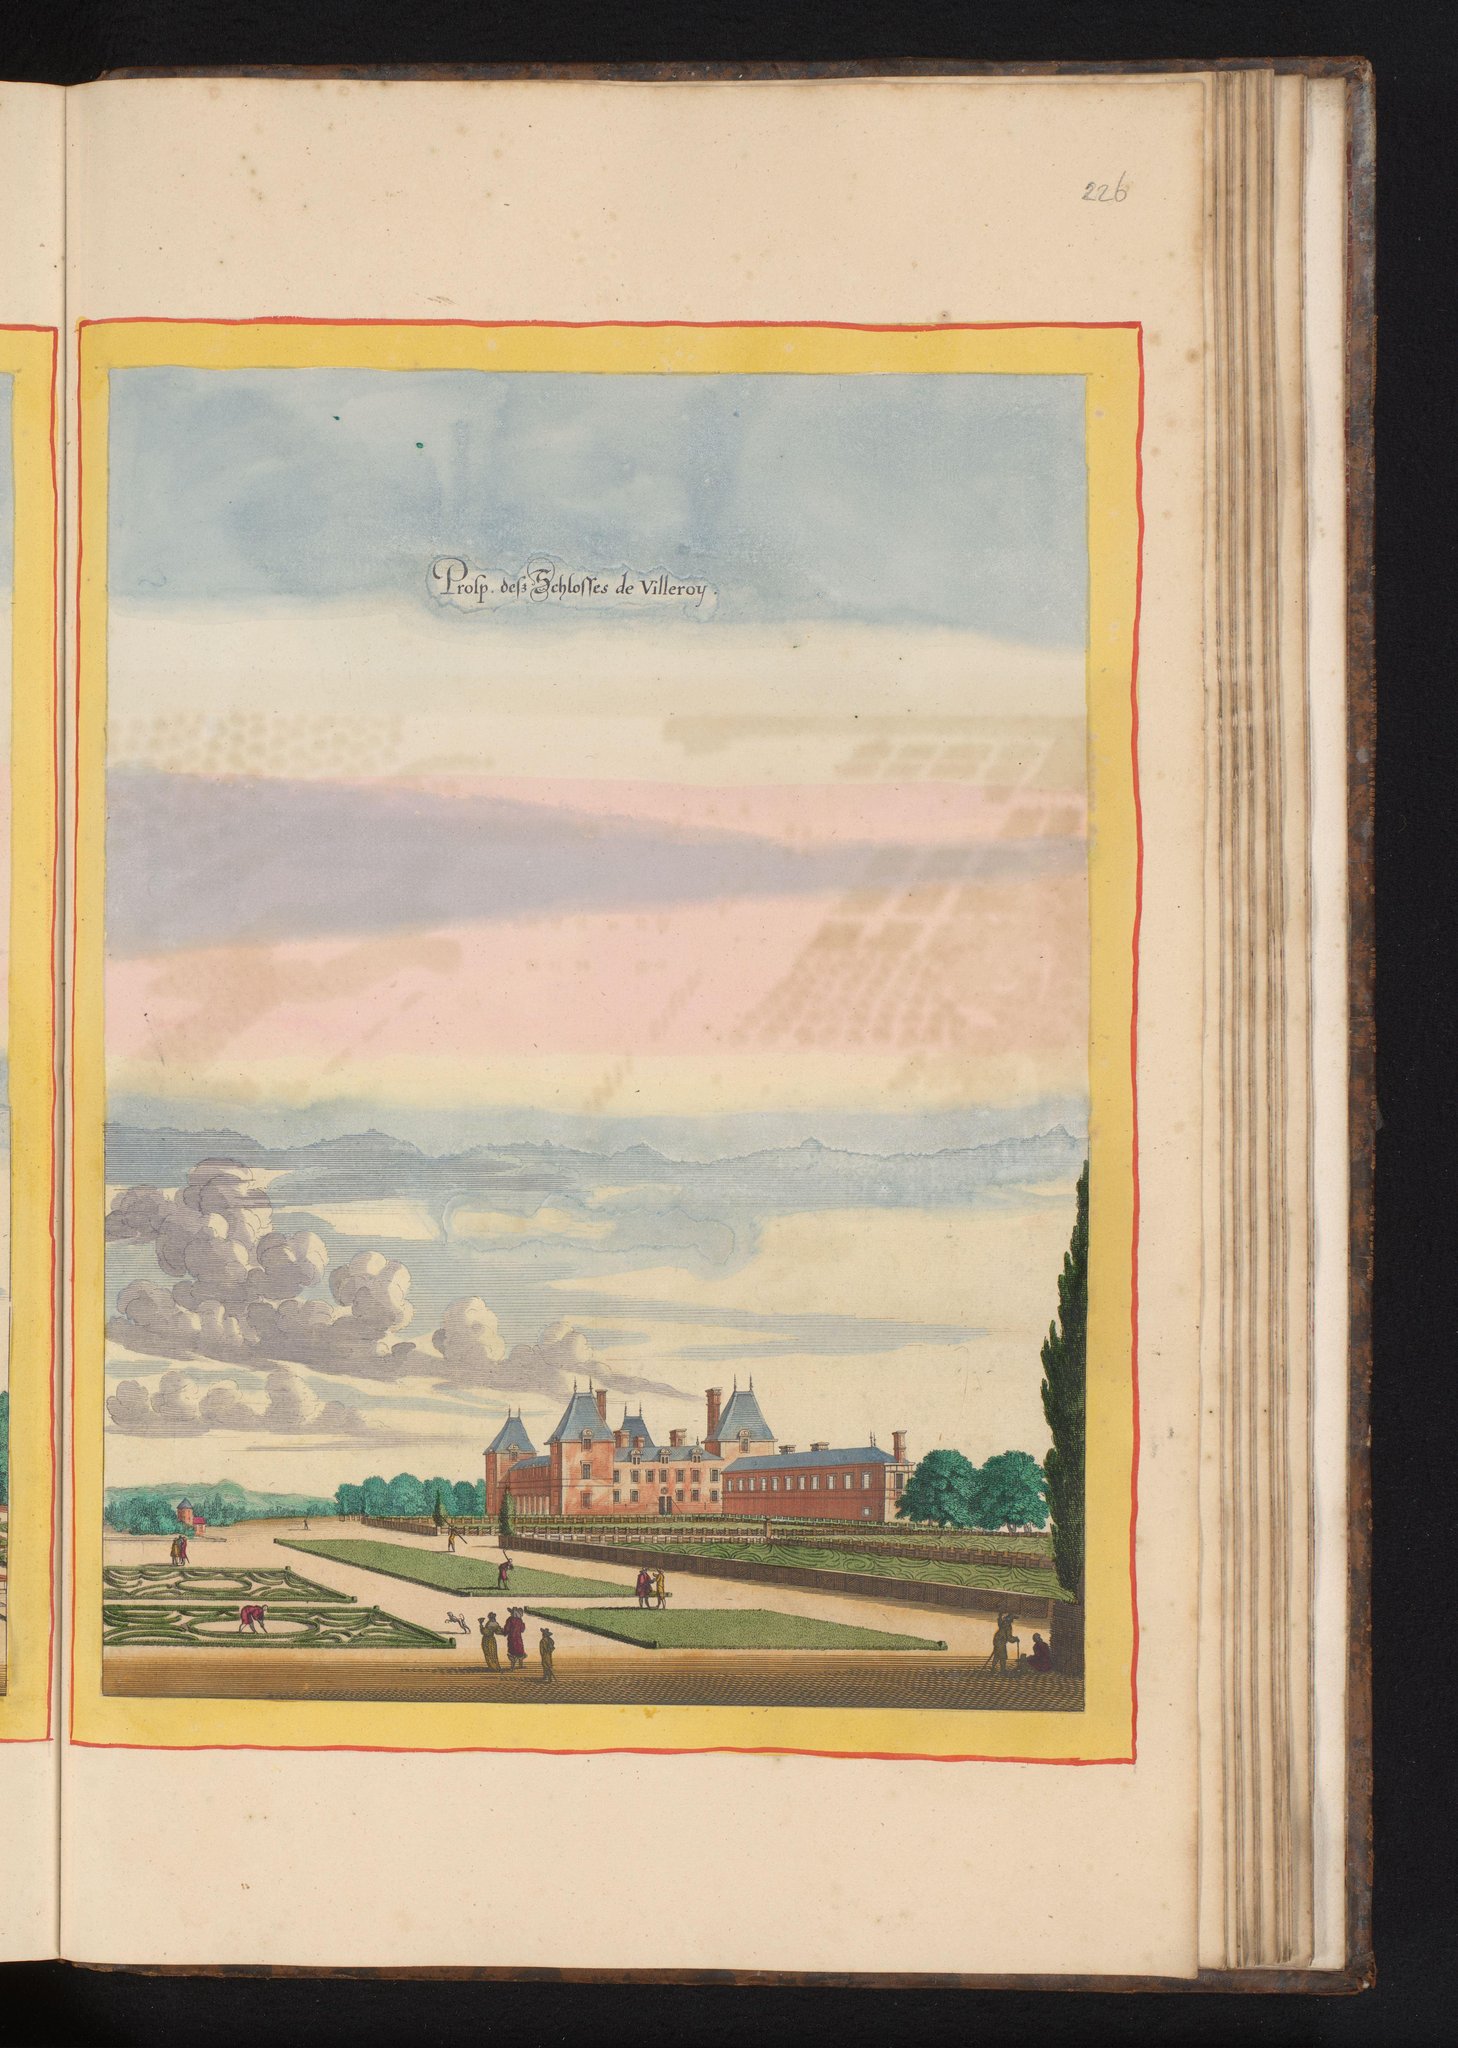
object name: print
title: Prosp. des Schlosses de Villeroy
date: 1655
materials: paper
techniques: engraving, etching, hand coloring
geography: the hague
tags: castle, french or architectonic garden; formal garden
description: Prent origineel vervaardigd als boekillustratie voor: Zeiller, Martin. Topographia Galliae, oder Beschreibung und Contrafaitung der vornehmbsten und bekantisten Oerter in dem mächtigen und grossen Königreich Frankreich, 13 delen. Frankfurt am Main: Caspar Merian, 1655-1661. De prent werd voor het eerst gepubliceerd in deel 1: Topographia Galliae, 1655. De prent is langs de bovenrand van de voorstelling afgescheurd. De titel is hoger opgeplakt. De voorstelling is aan de bovenzijde aangevuld met een geschilderde lucht.